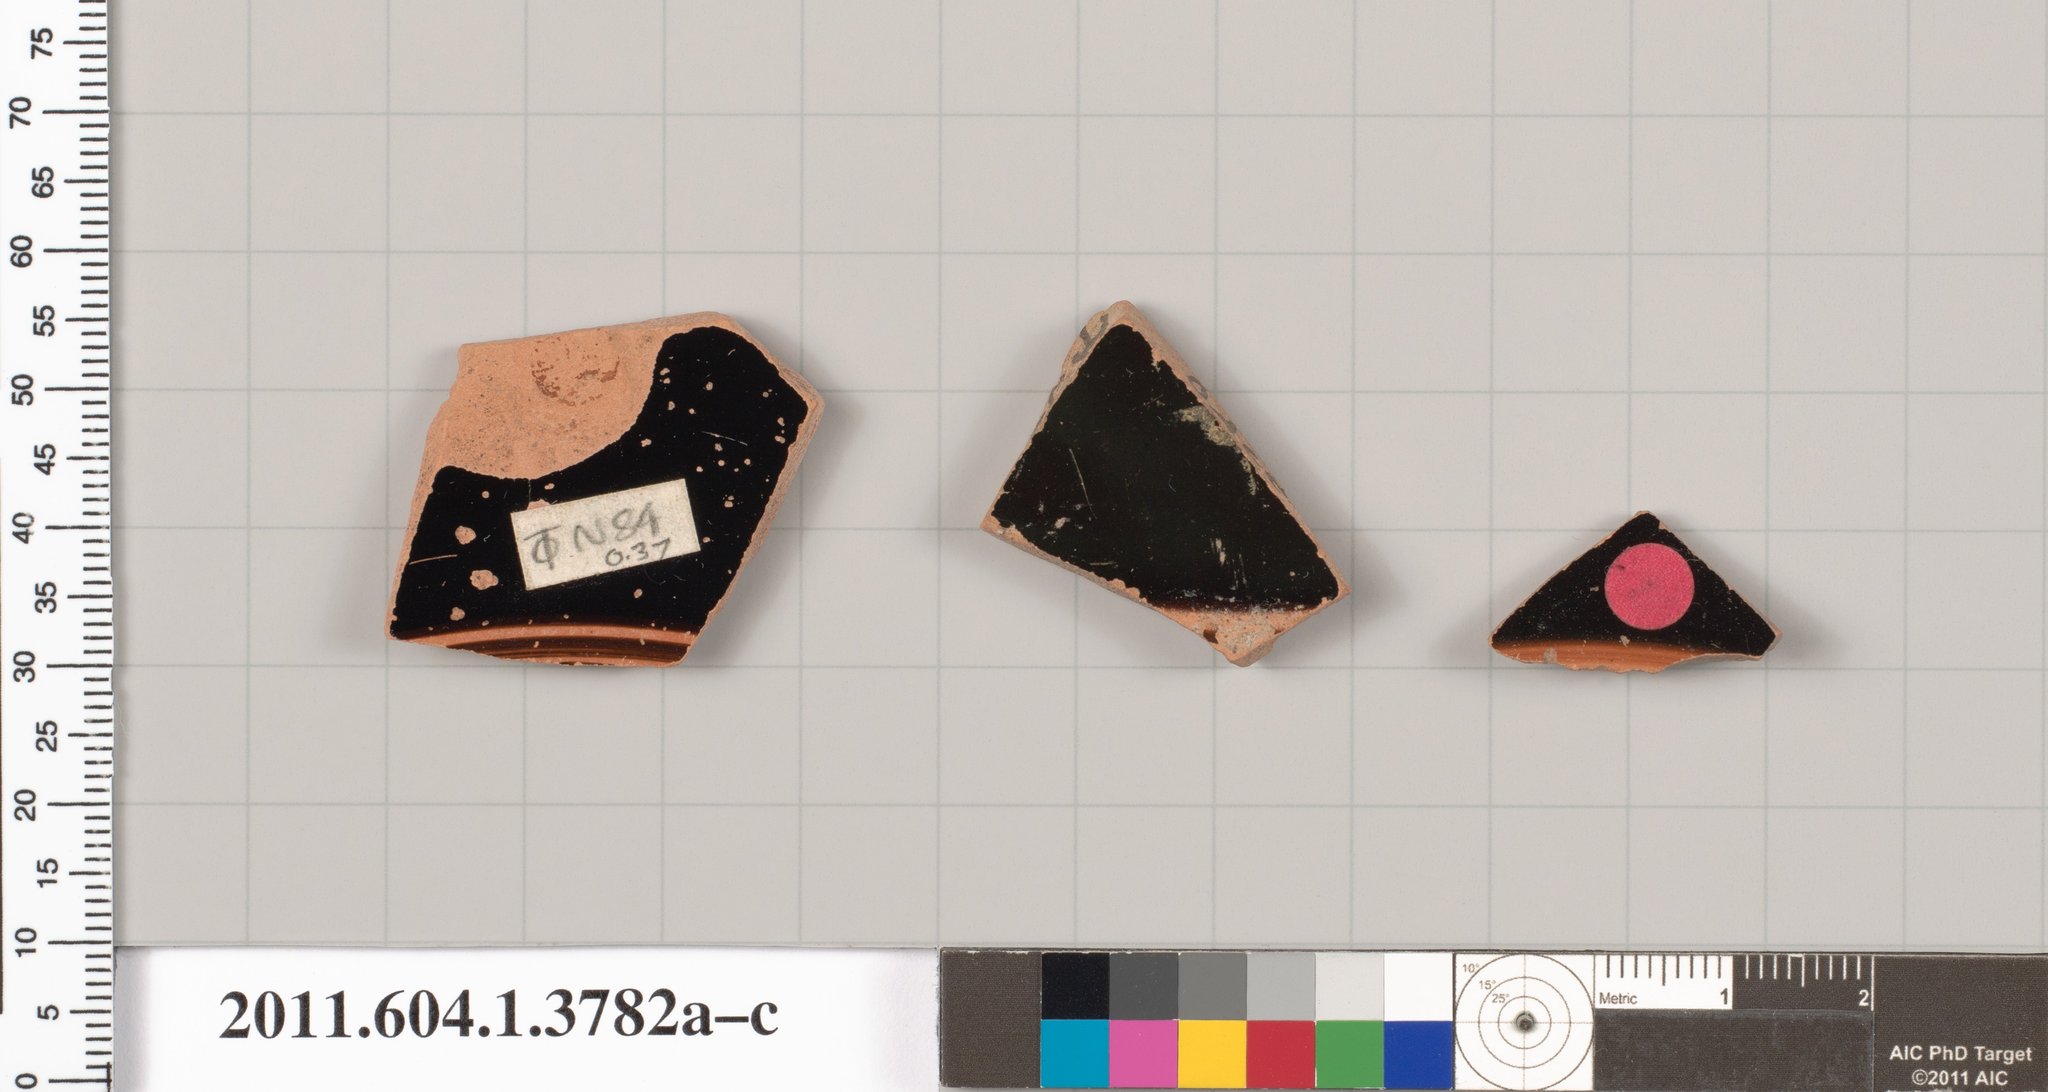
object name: kylix fragment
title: Terracotta fragments of kylikes (drinking cups)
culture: greek, attic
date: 401-450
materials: terracotta